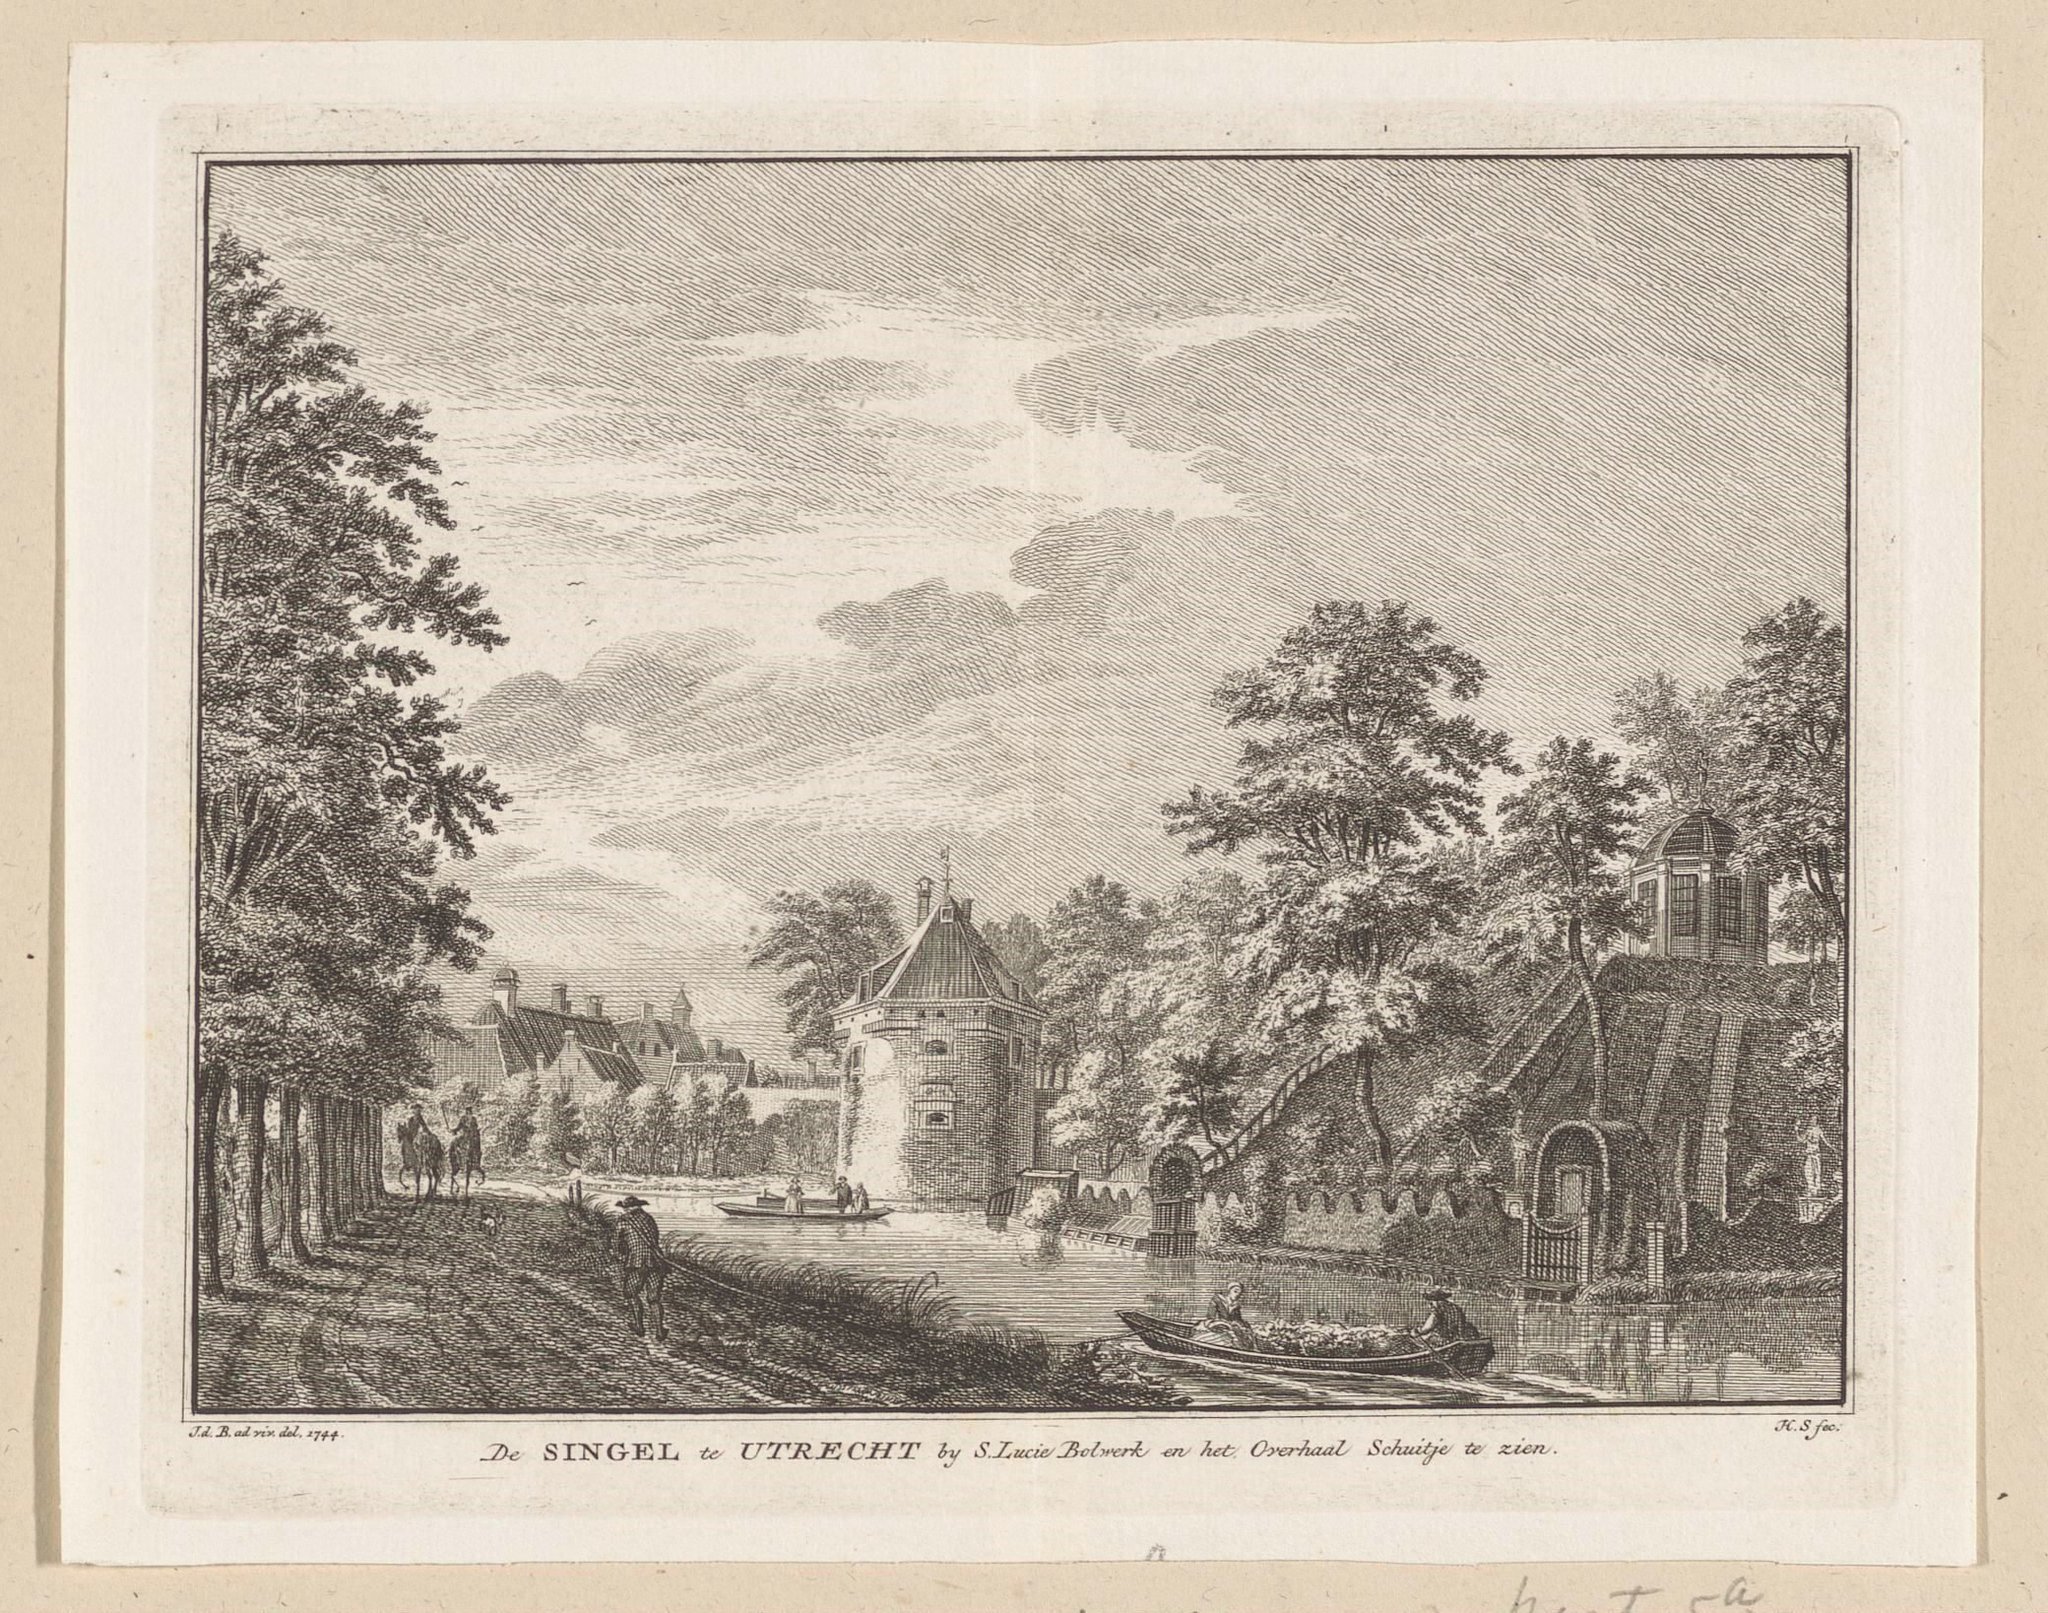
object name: print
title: De Singel te Utrecht by S. Lucie bolwerk en het Overhaal Schuitje te zien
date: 1773-1792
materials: paper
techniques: engraving, etching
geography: haarlem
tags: towers ~ fortified city, city-walls, bastion, bulwark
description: Prent ook gebruikt in: Het verheerlykt Nederland of kabinet van hedendaagsche gezigten van steden, dorpen (…) Behelzende honderd gezigten van der Provincie van Utrecht. Amsterdam: weduwe Isaak Tirion, 1773-1774, dl. 7, 8 of 9, niet genummerd, te vinden na ill. 144 en voor ill. 201. Of in: Nederlandsche tafereelen; of eene keurige verzameling van negen honderd fraaije gezigten van steden, dorpen, sloten, oudheden (….). 9 delen. Amsterdam: Jan de Groot, 1792, dl. 7, 8 of 9, niet genummerd, te vinden na ill. 144 en voor ill. 201. Uit welke druk het huidige exemplaar precies komt is niet na te gaan.